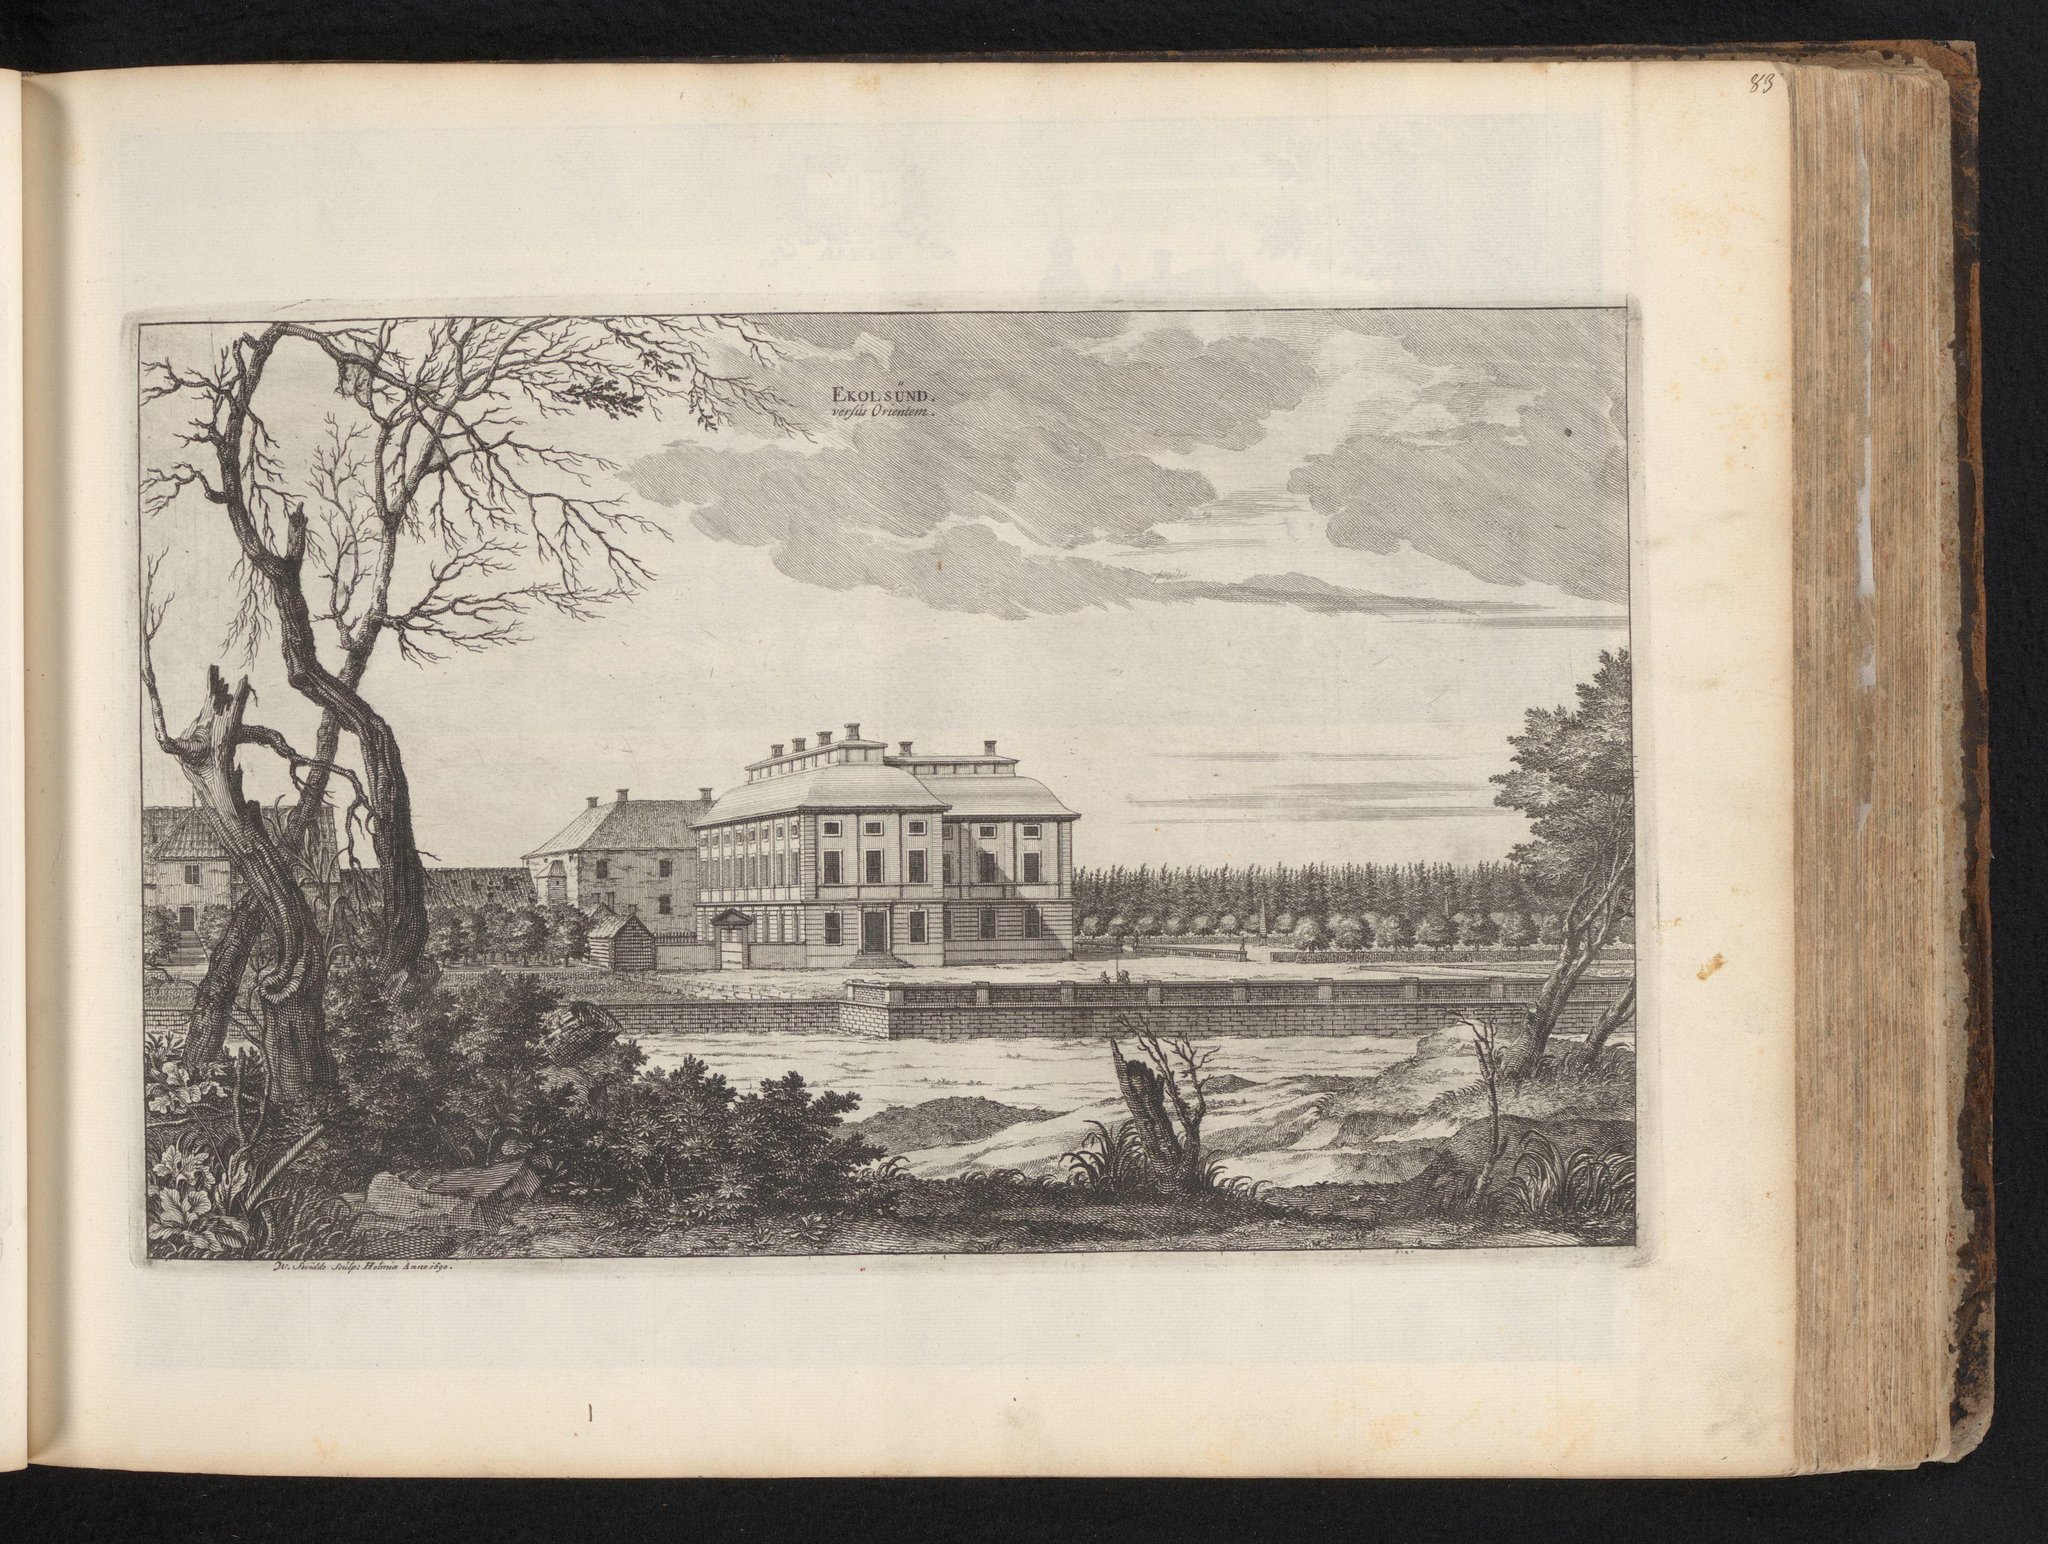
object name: album leaf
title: Ekolsund versus Orientem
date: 1690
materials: paper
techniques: etching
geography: stockholm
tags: palace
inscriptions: date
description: Kungliga Biblioteket, 'Suecia': http://www.kb.se/samlingarna/Kartor-bilder/Suecia-antiqua/ (geraadpleegd november 2016).